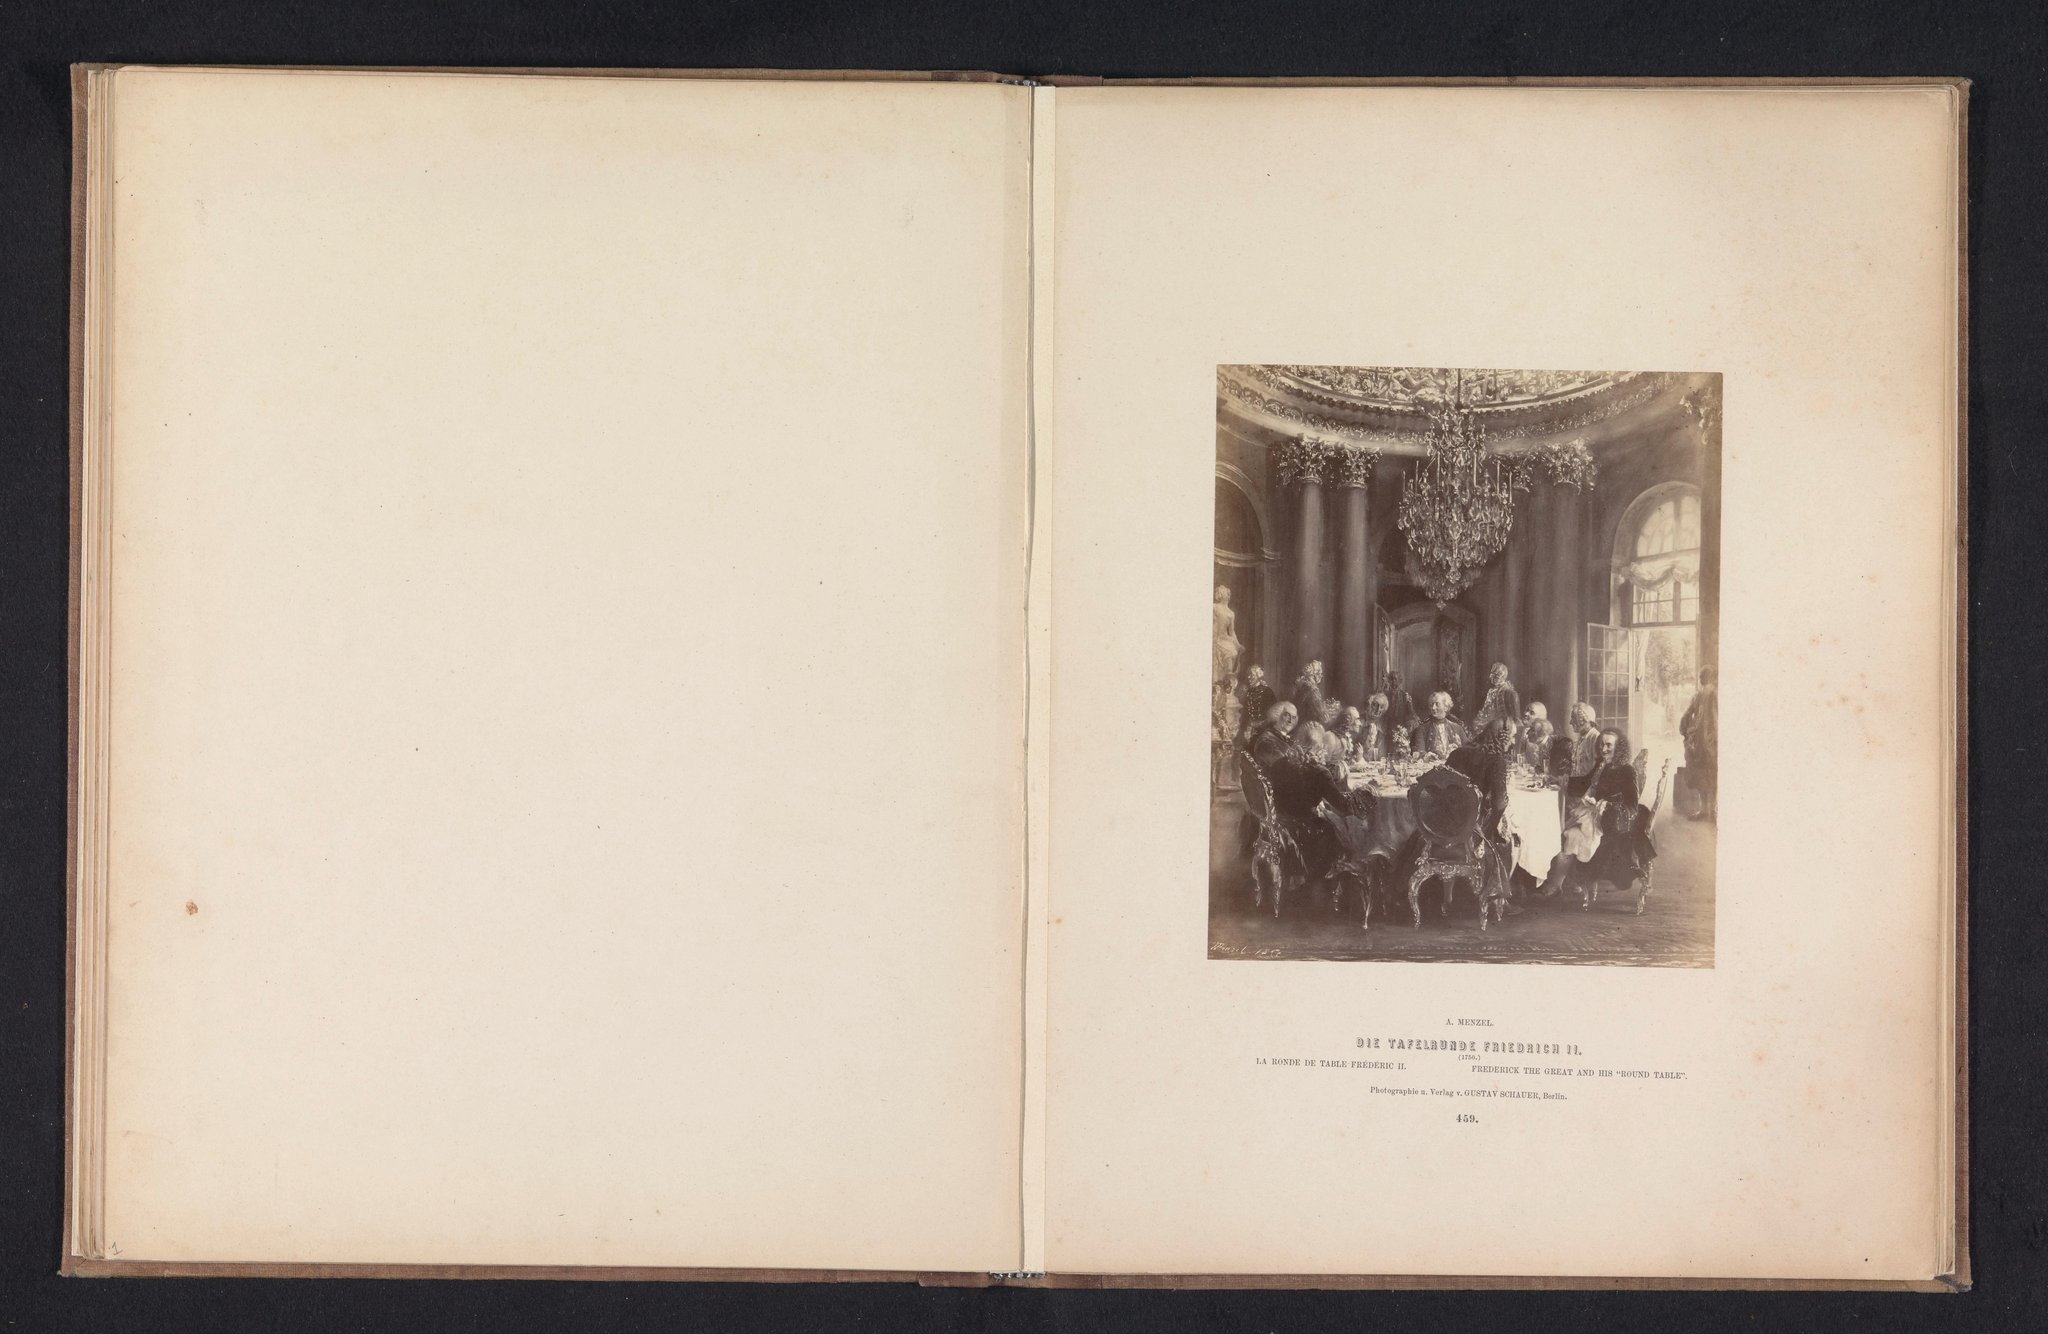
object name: reproduction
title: Die Tafelrunde Friedrich II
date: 1858-1868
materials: photographic support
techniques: albumen print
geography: berlin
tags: berlin, frederick ii (king of prussia), table-ware, evening meal, dinner, supper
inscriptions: number: ‘459.’